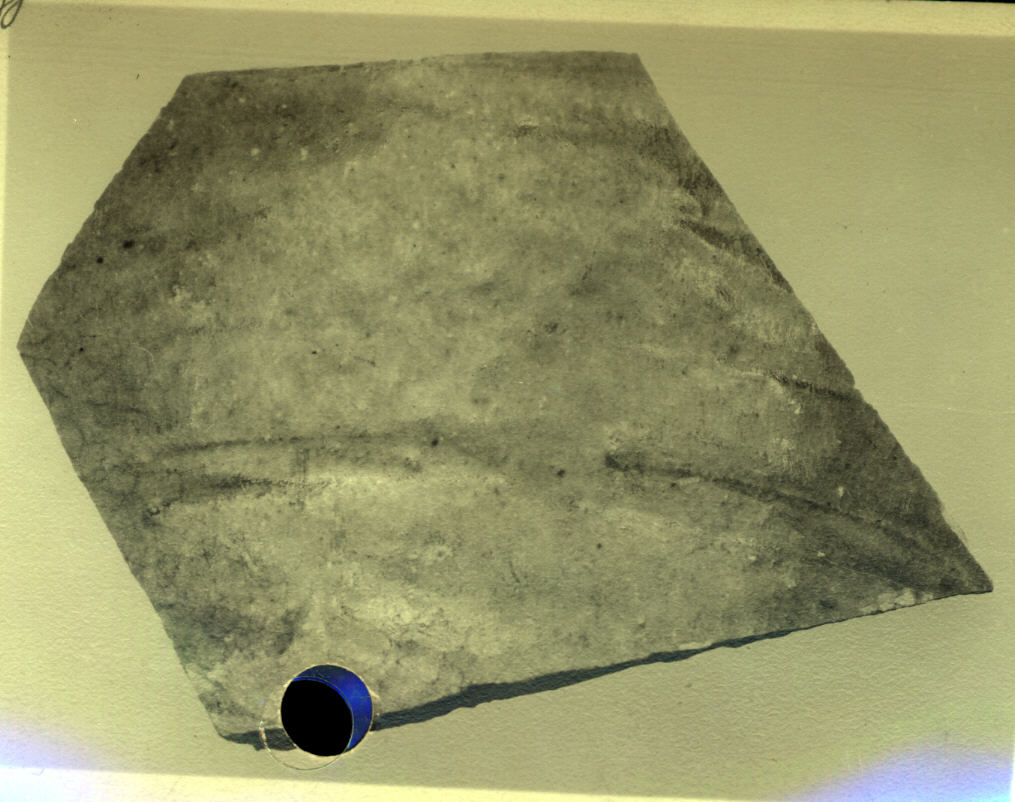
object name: fragment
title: Ceramic Fragment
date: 801-900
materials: earthenware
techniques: glazing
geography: iraq